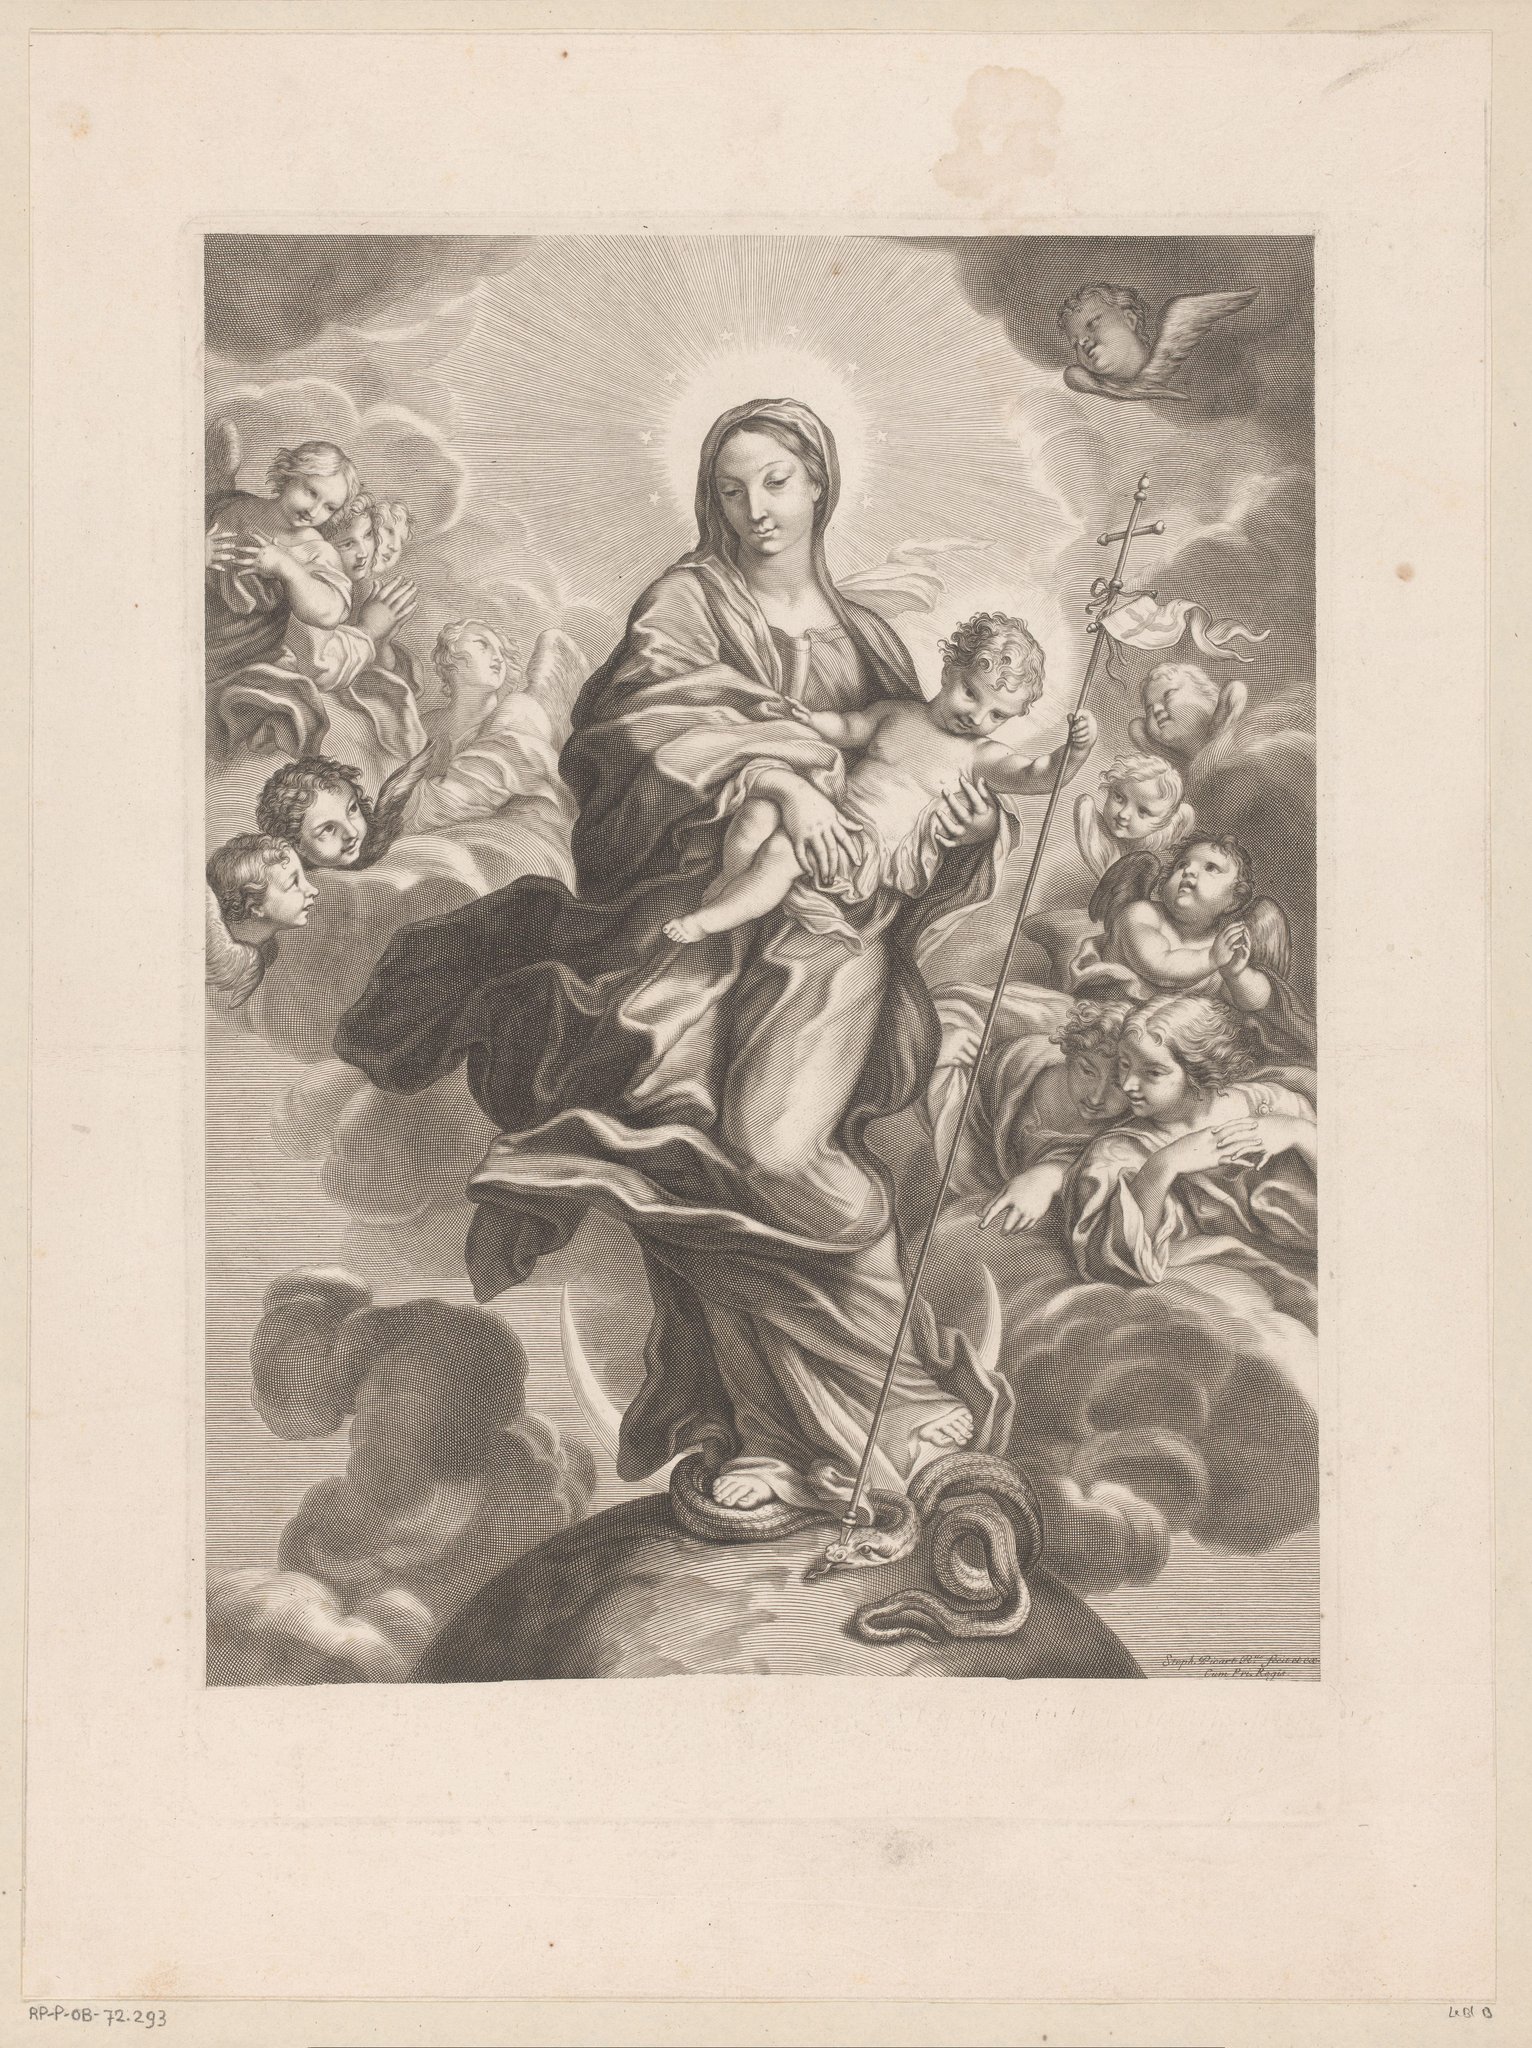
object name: print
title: Maria met Kind op wereldbol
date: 1665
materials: paper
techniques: engraving, etching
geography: france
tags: mary standing (or half-length), the christ-child lying on her arm (christ-child to mary's left), 'immaculata', 'purisima': mary, usually standing on a crescent moon, descending from heaven, exempt from original sin (sometimes trampling serpent), christ triumphing over devil(s), mary standing or resting on the earth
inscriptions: collector's mark: Lugt 2165